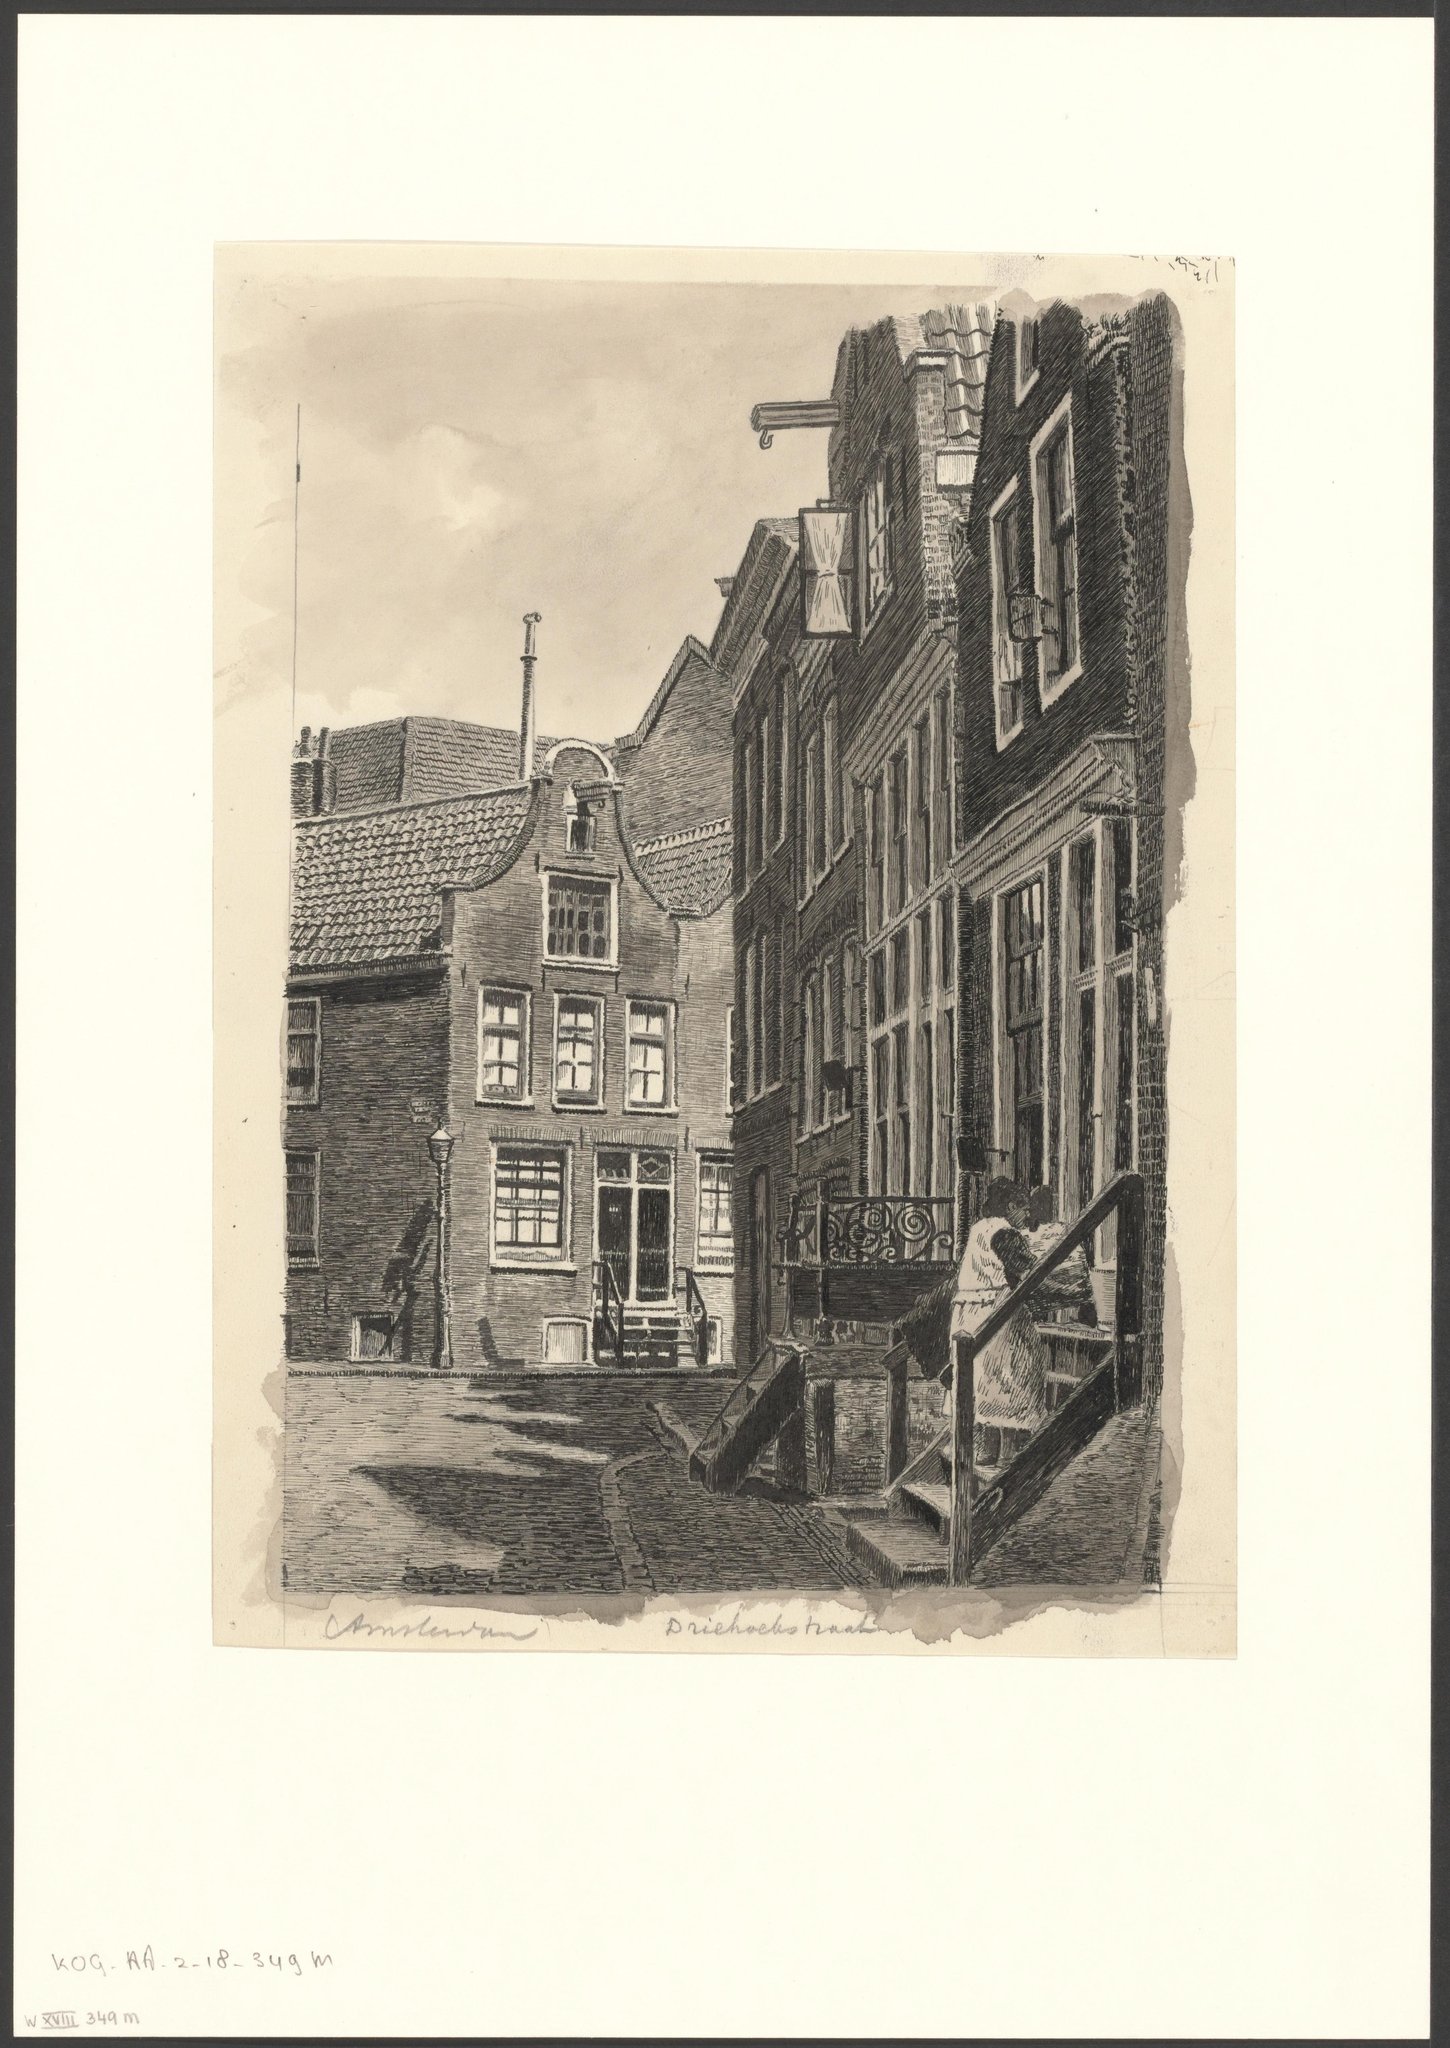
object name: drawing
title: Gezicht op de Driehoekstraat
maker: Anonymous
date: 1875-1975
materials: ink, paper, pencil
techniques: brush, pen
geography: amsterdam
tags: city-view in general; 'veduta', street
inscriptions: inscription: ‘Amsterdam Driehoekstraat’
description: Tekening binnen de Atlas Van Eck ingedeeld op wijknummer 18.